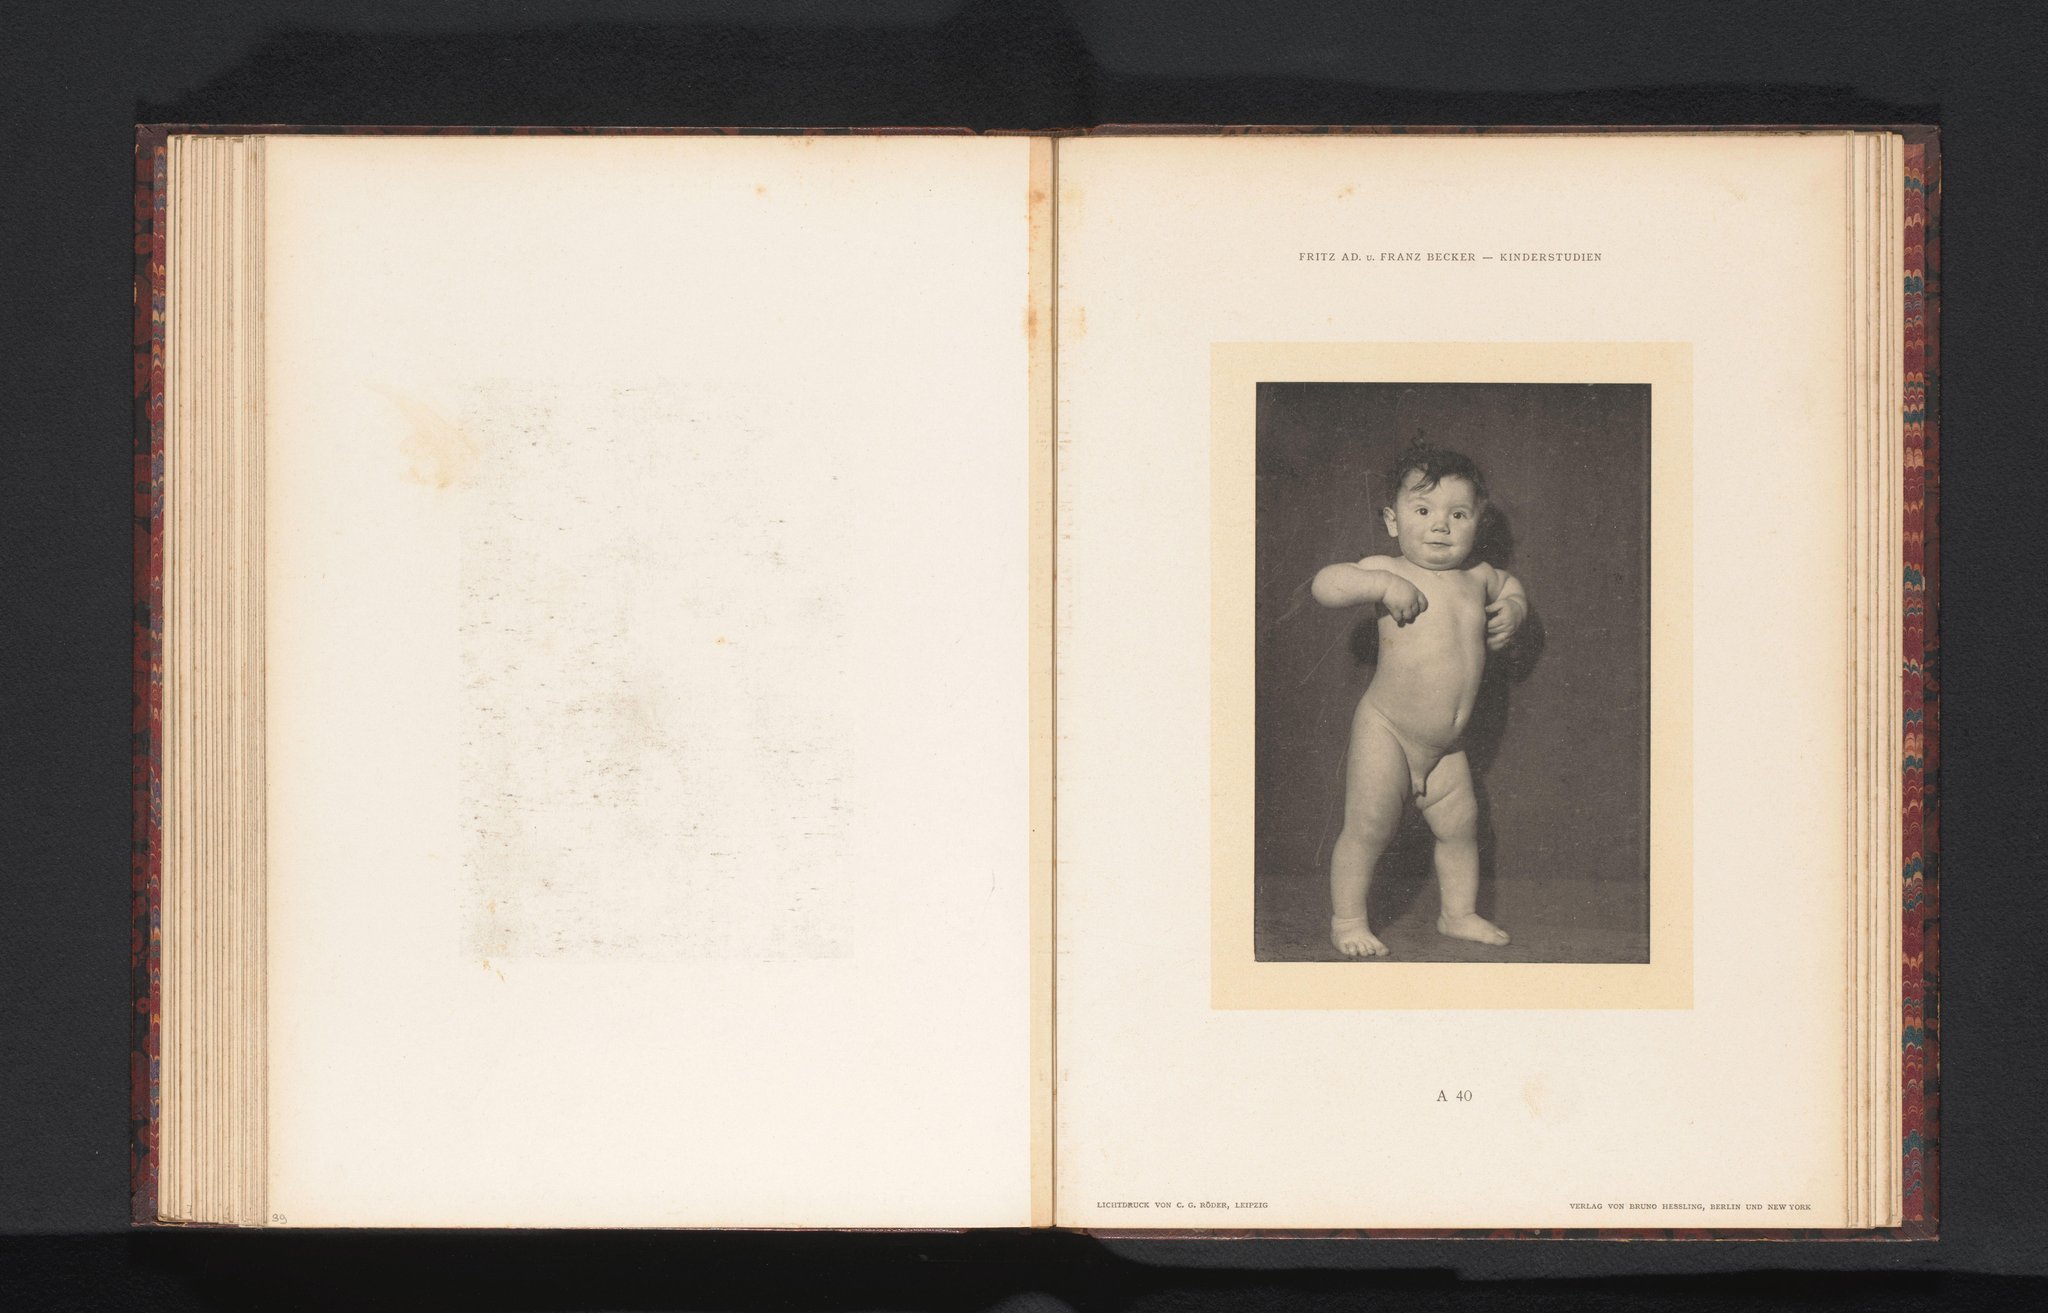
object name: page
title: Staande naakte jongen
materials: paper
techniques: photograph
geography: berlin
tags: standing figure, toddler (male)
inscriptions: number: ‘A 40’